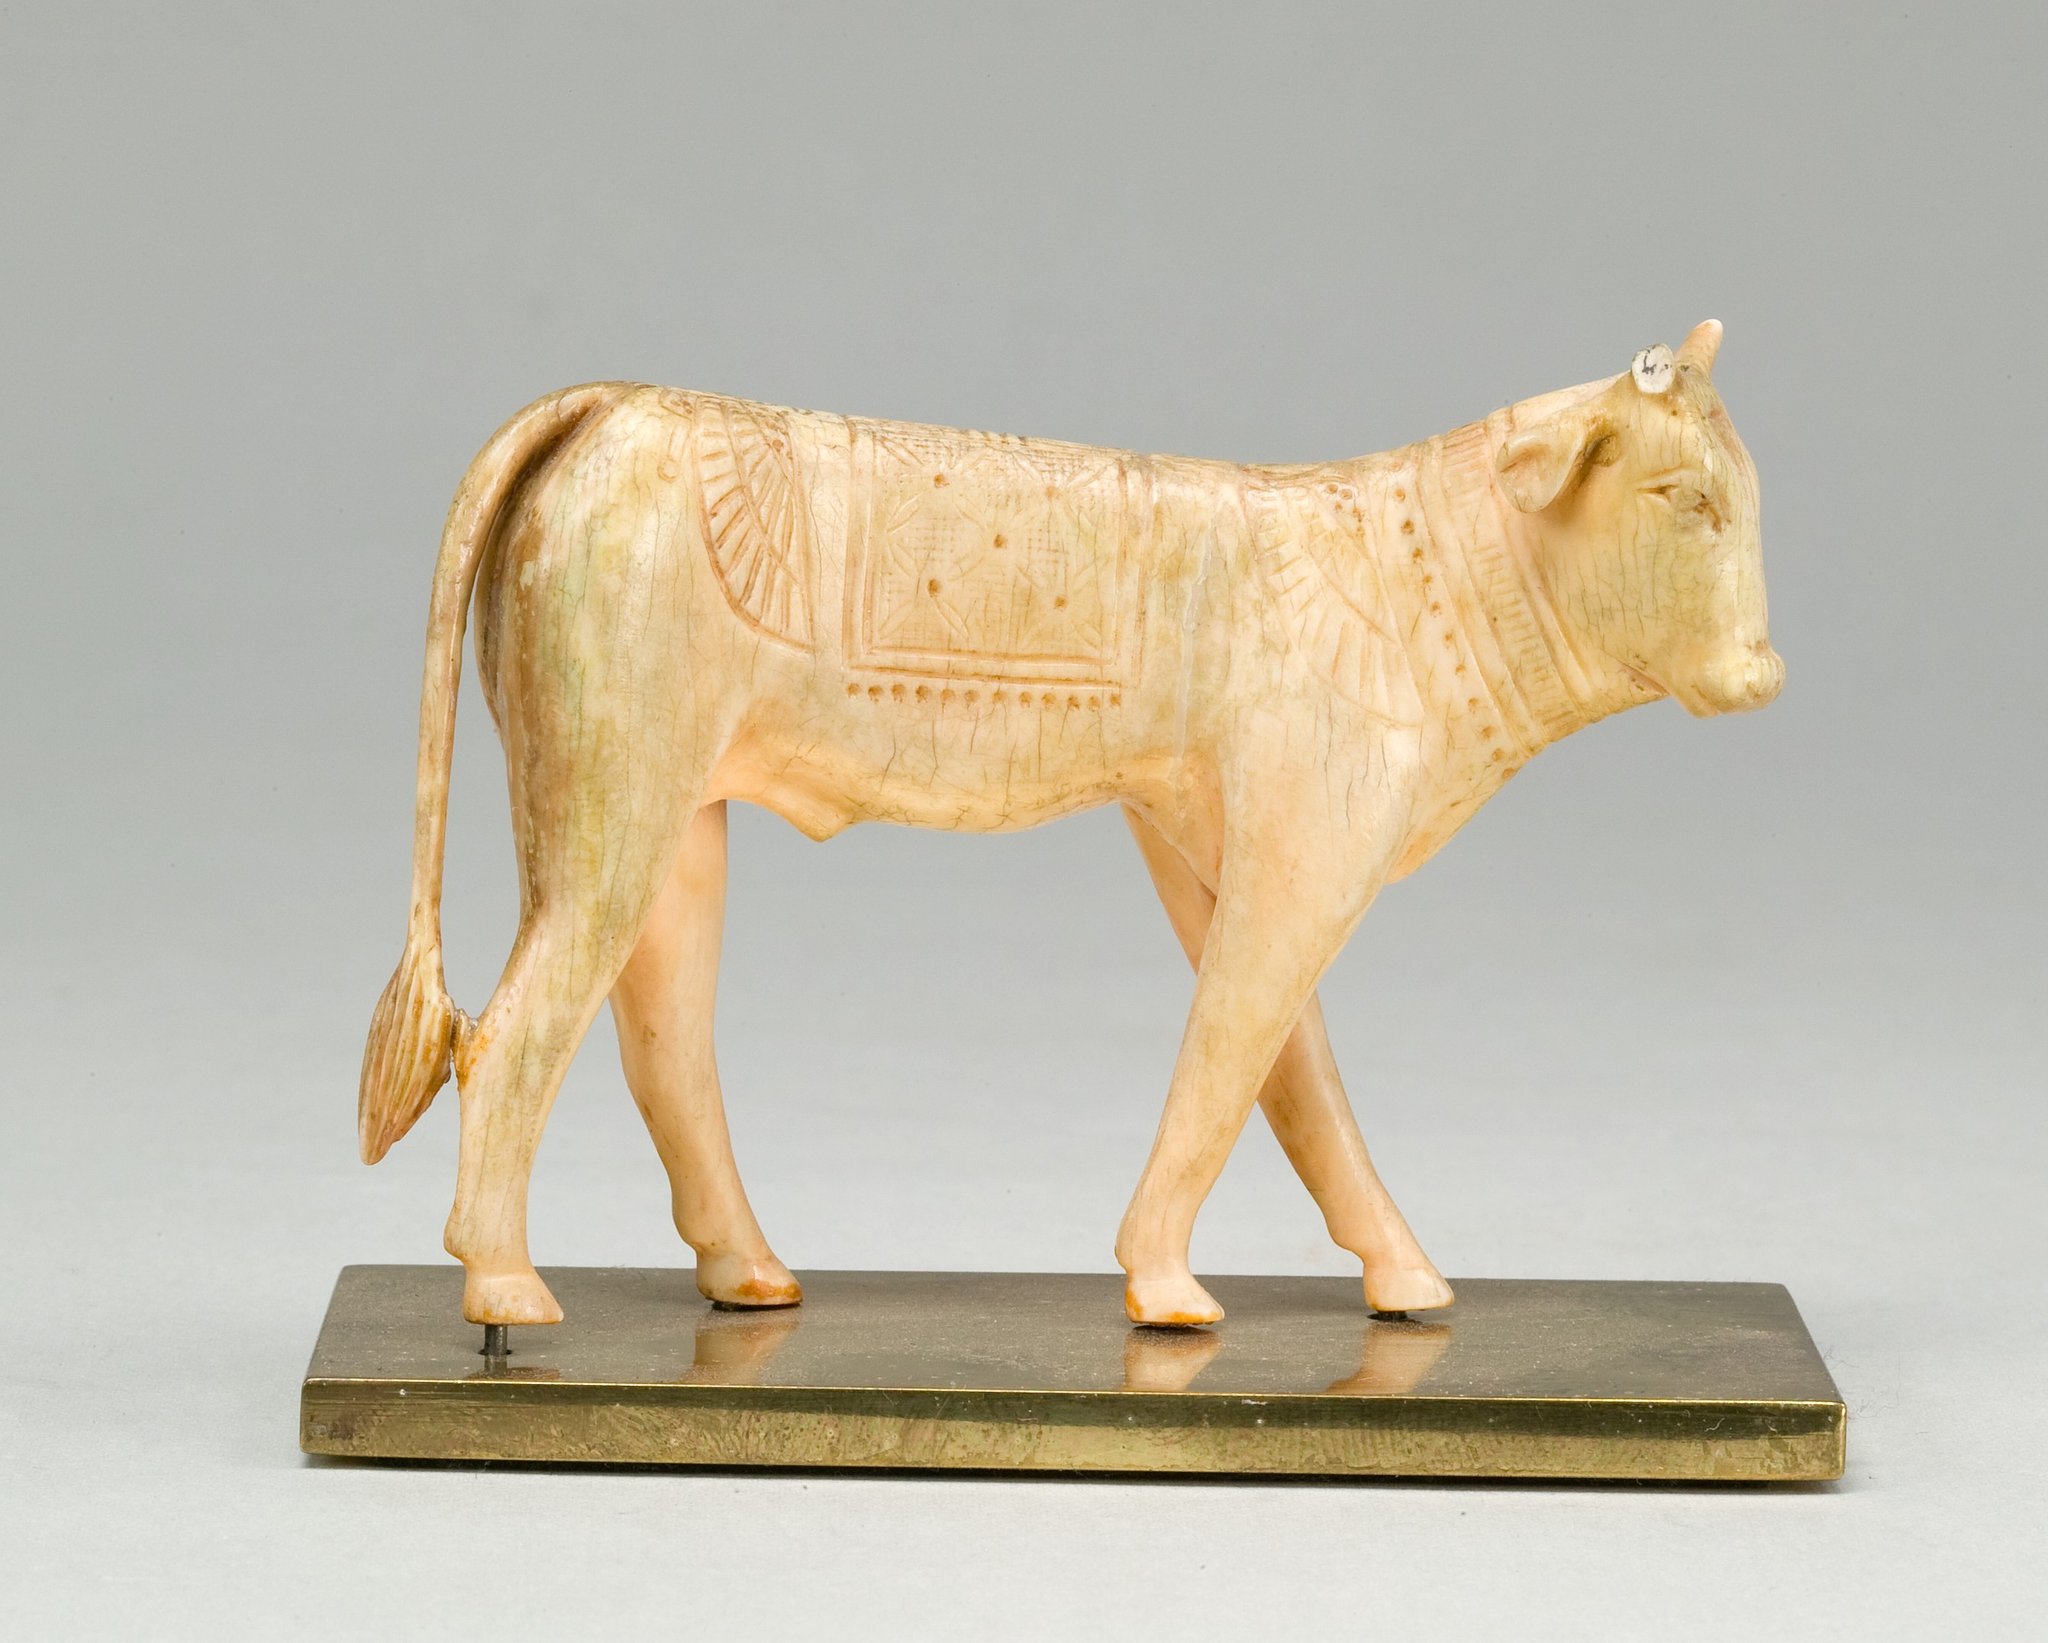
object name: statuette, apis bull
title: Apis Bull Statuette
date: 664-343 BCE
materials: ivory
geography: egypt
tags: bulls